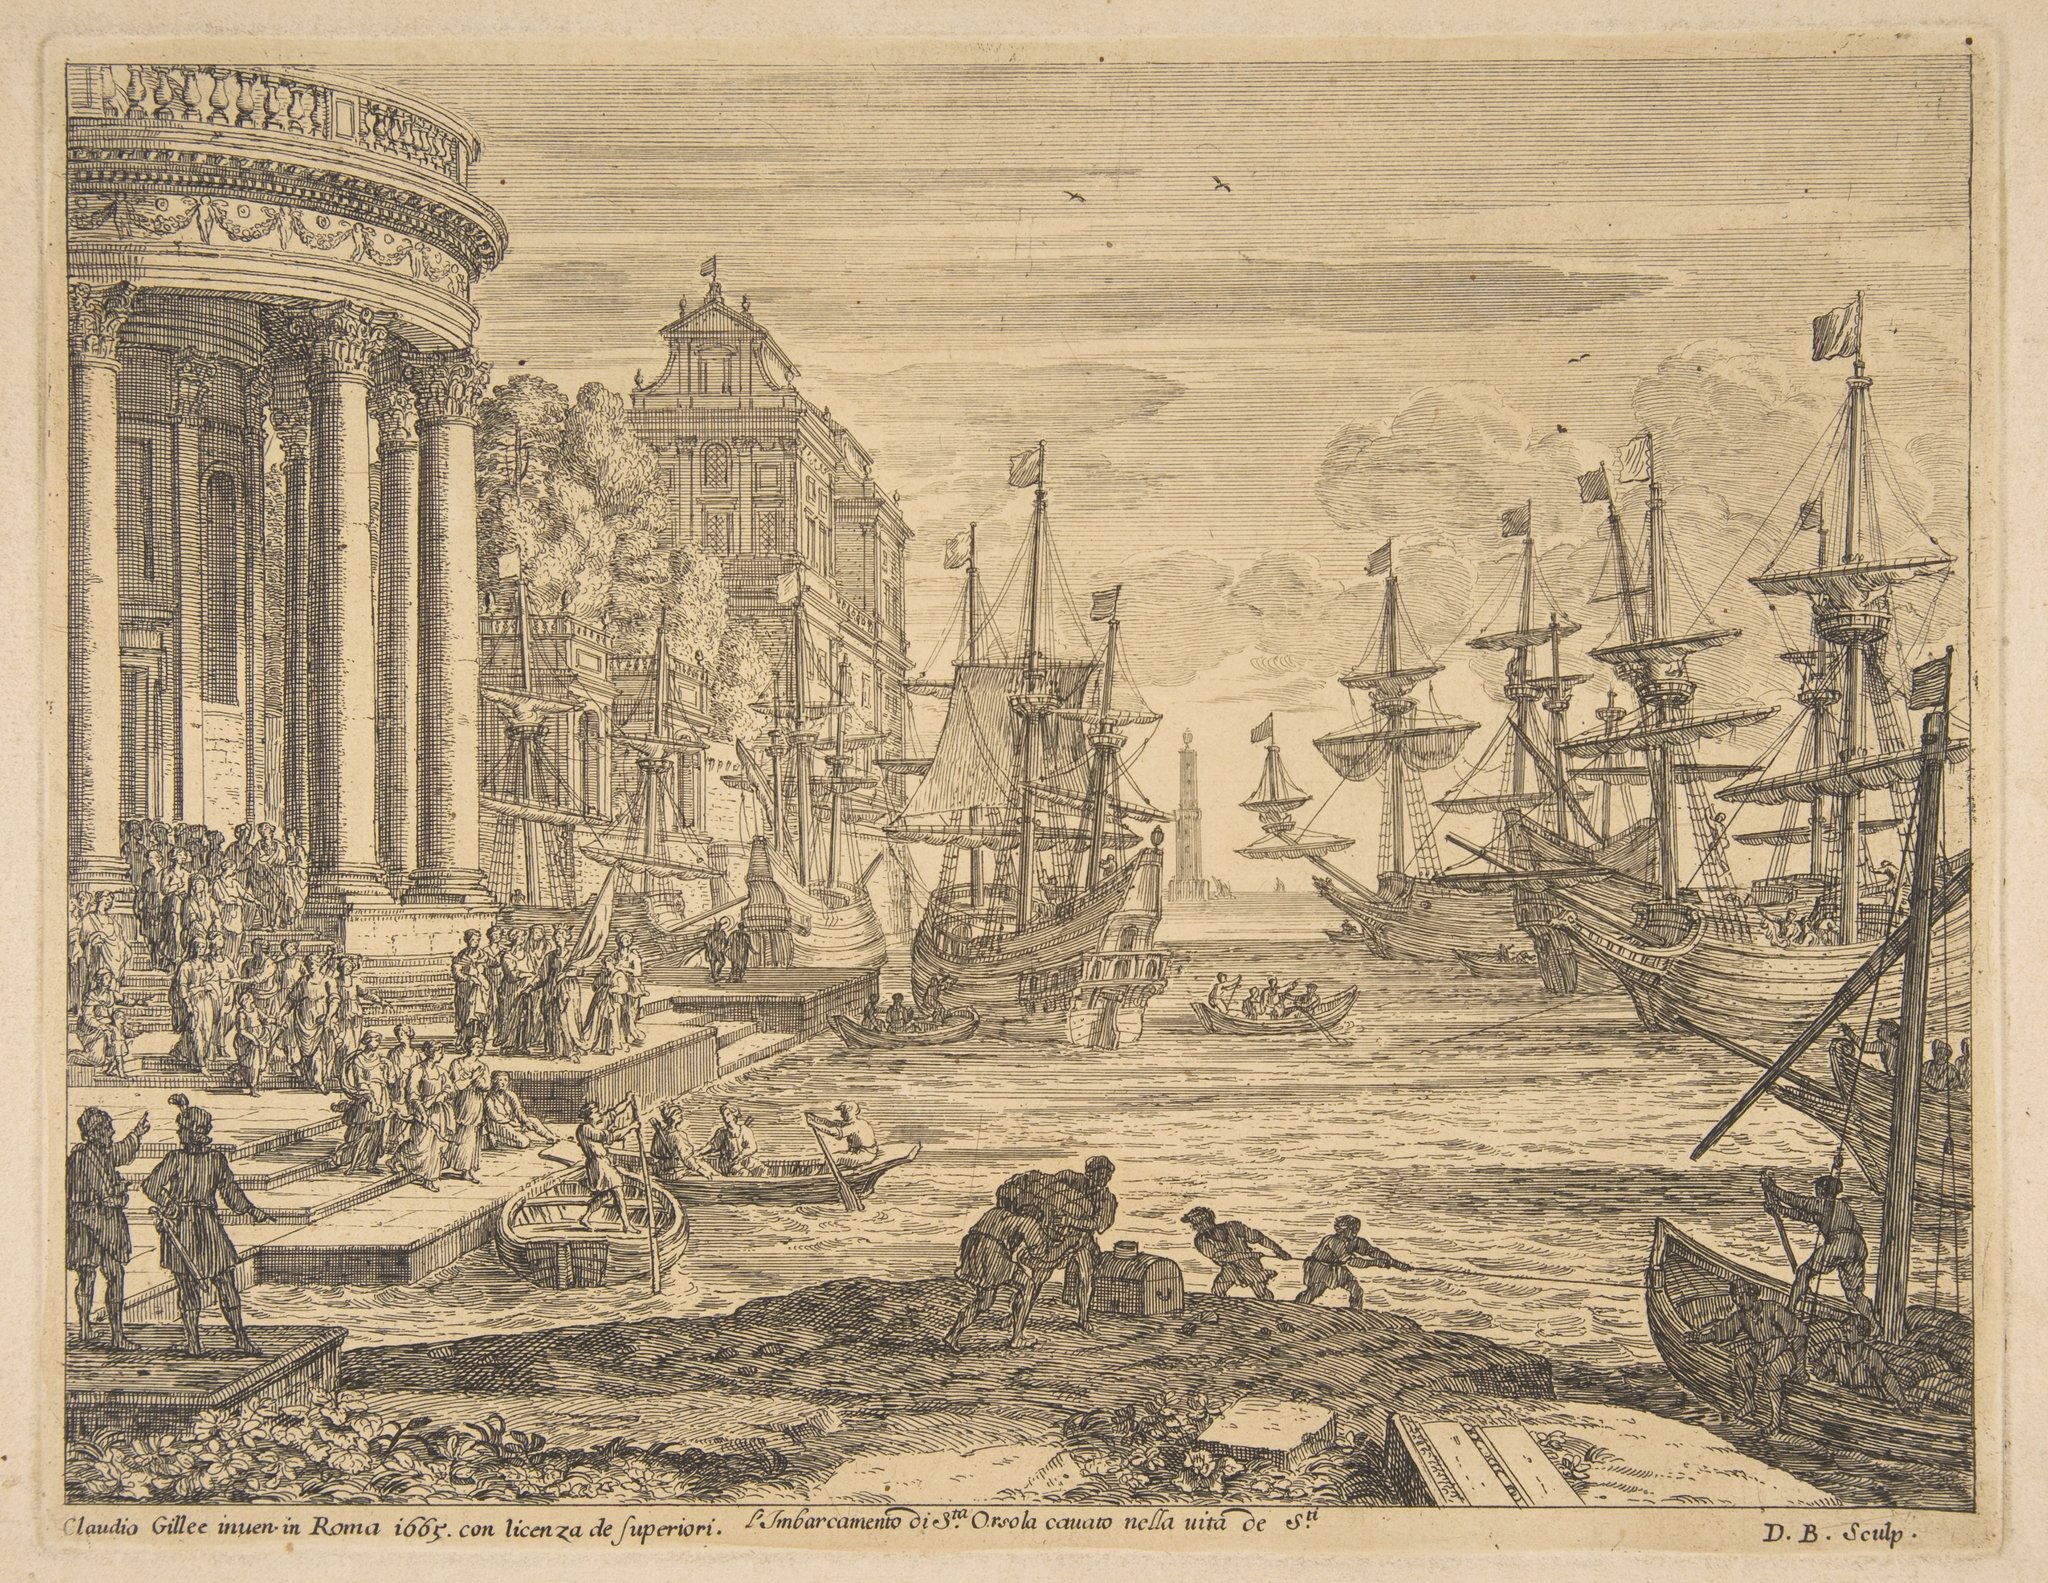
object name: print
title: Embarkation of St. Ursula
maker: claude lorrain (claude gellée)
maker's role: artist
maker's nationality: french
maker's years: 1604-1682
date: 1665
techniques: etching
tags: buildings,men,ships